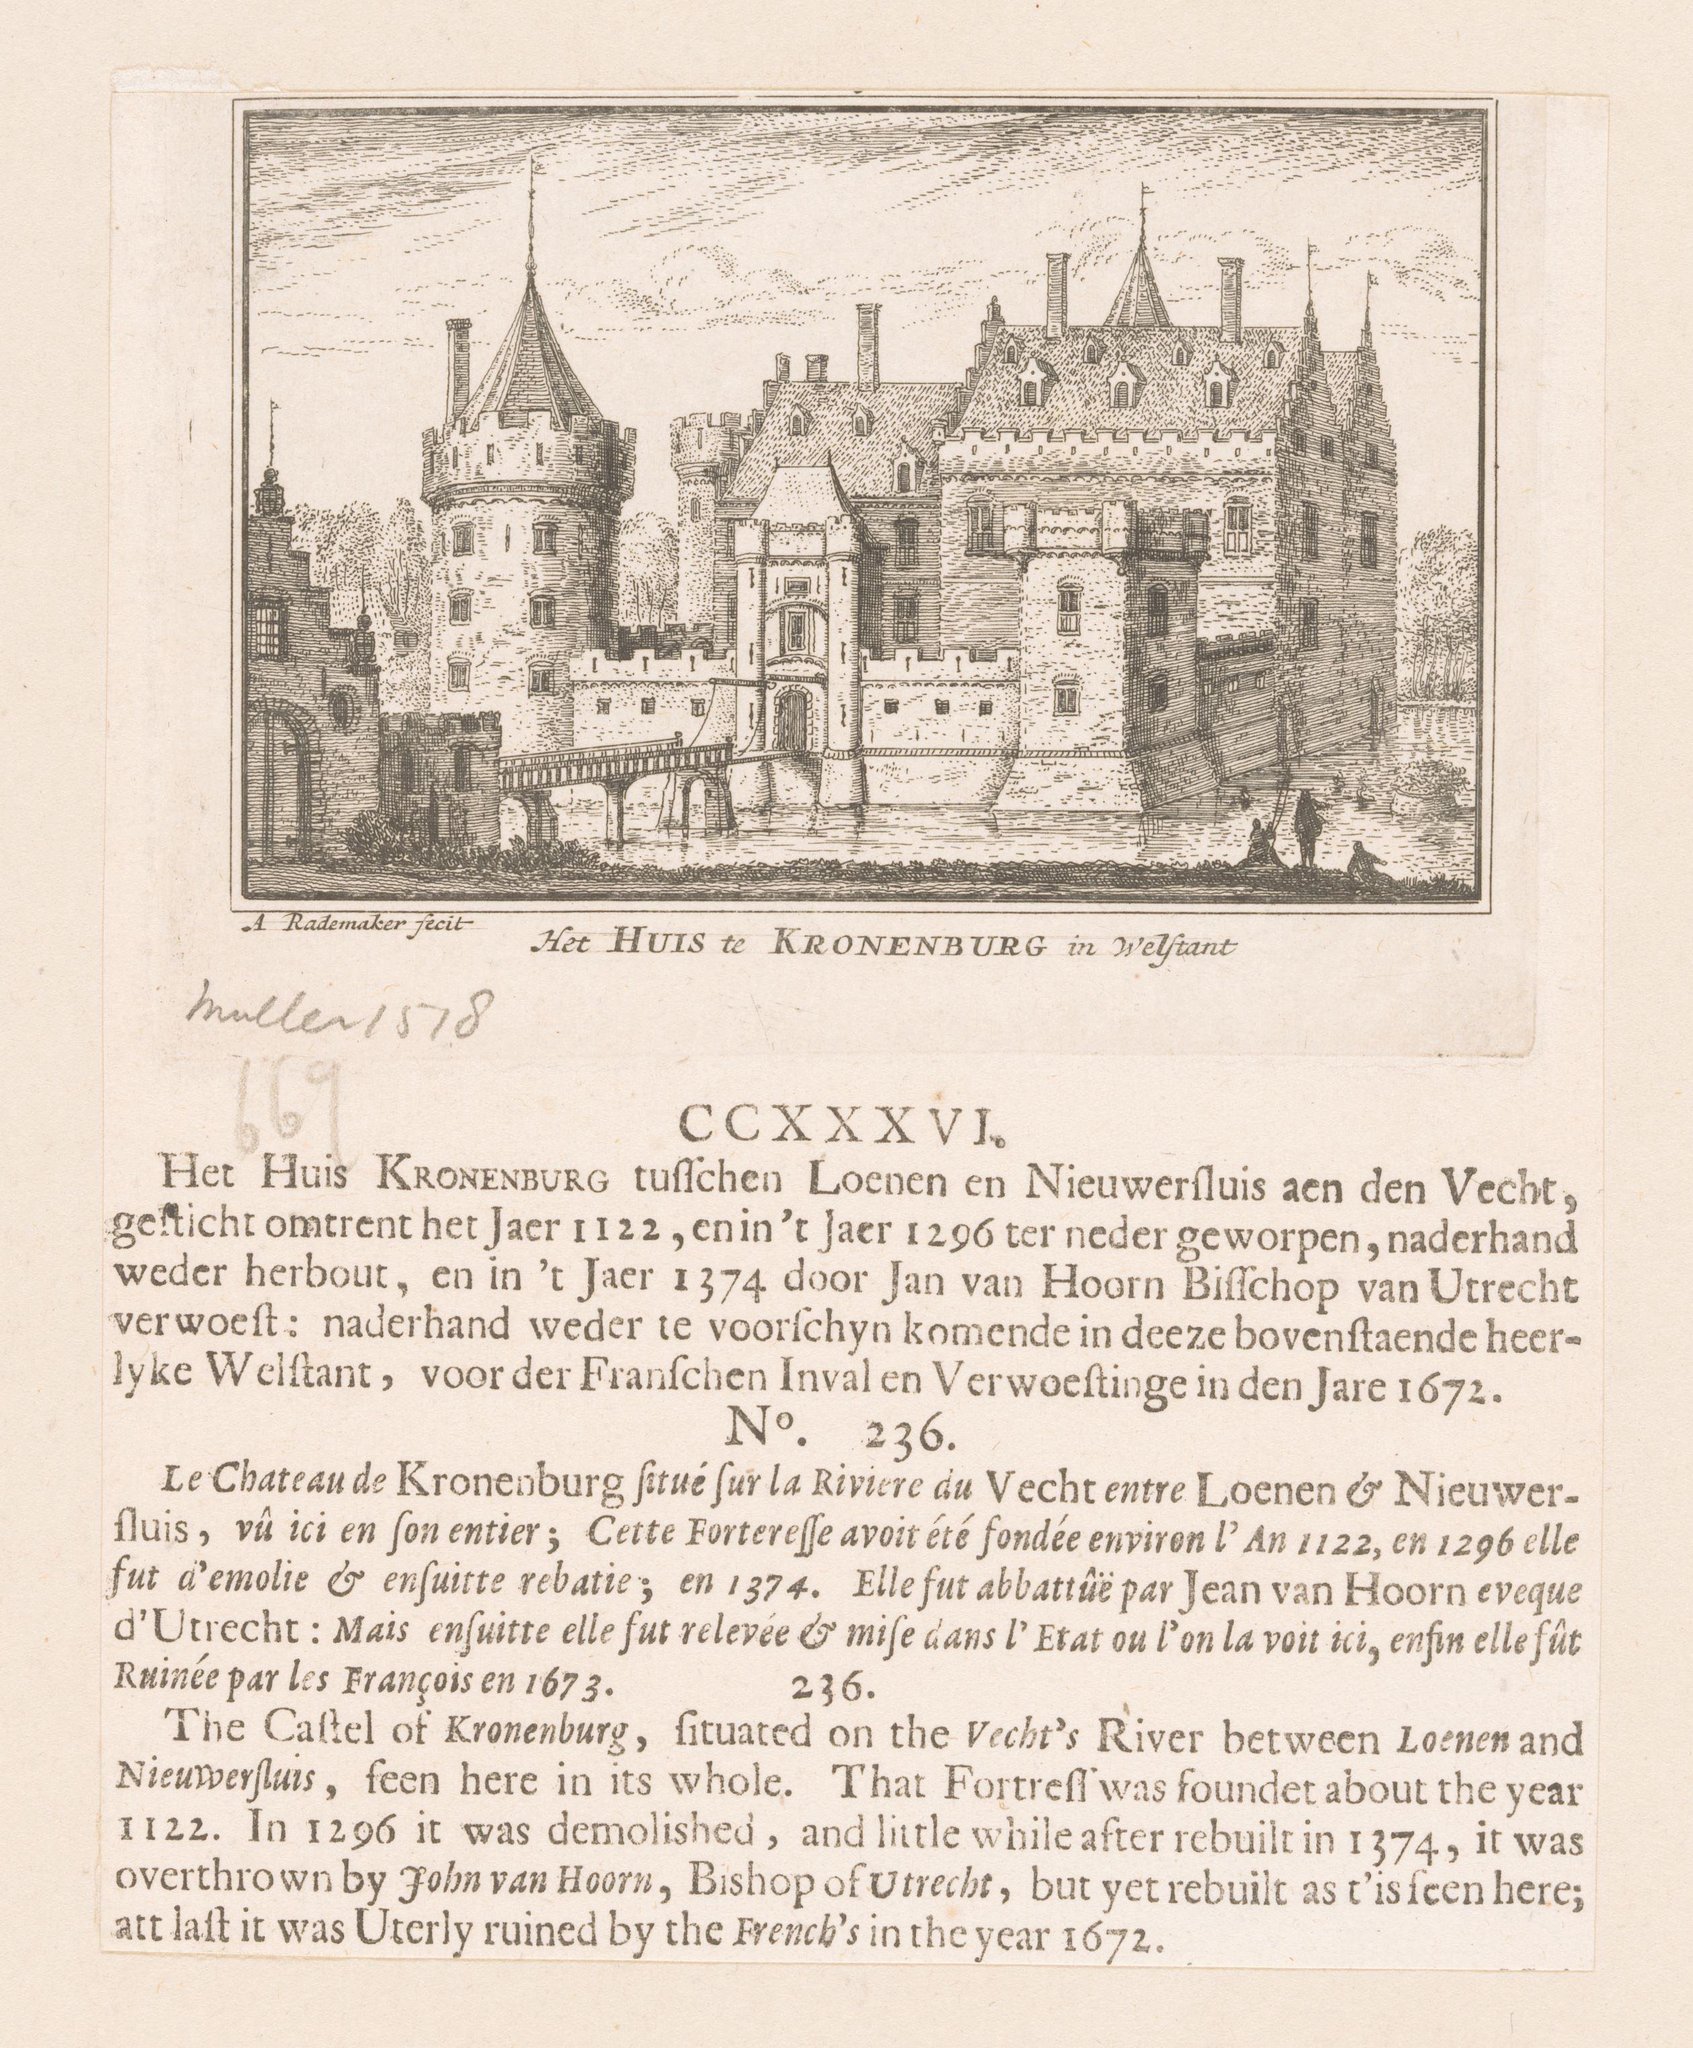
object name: book illustration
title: Het Huis te Kronenburg in Welstant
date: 1725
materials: paper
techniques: etching, letterpress printing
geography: amsterdam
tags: castle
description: Prent uit: Rademaker, Abraham. Kabinet van Nederlandsche outheden en gezichten: vervat in 300 konstplaten. Amsterdam: Willem Barents, 1725.